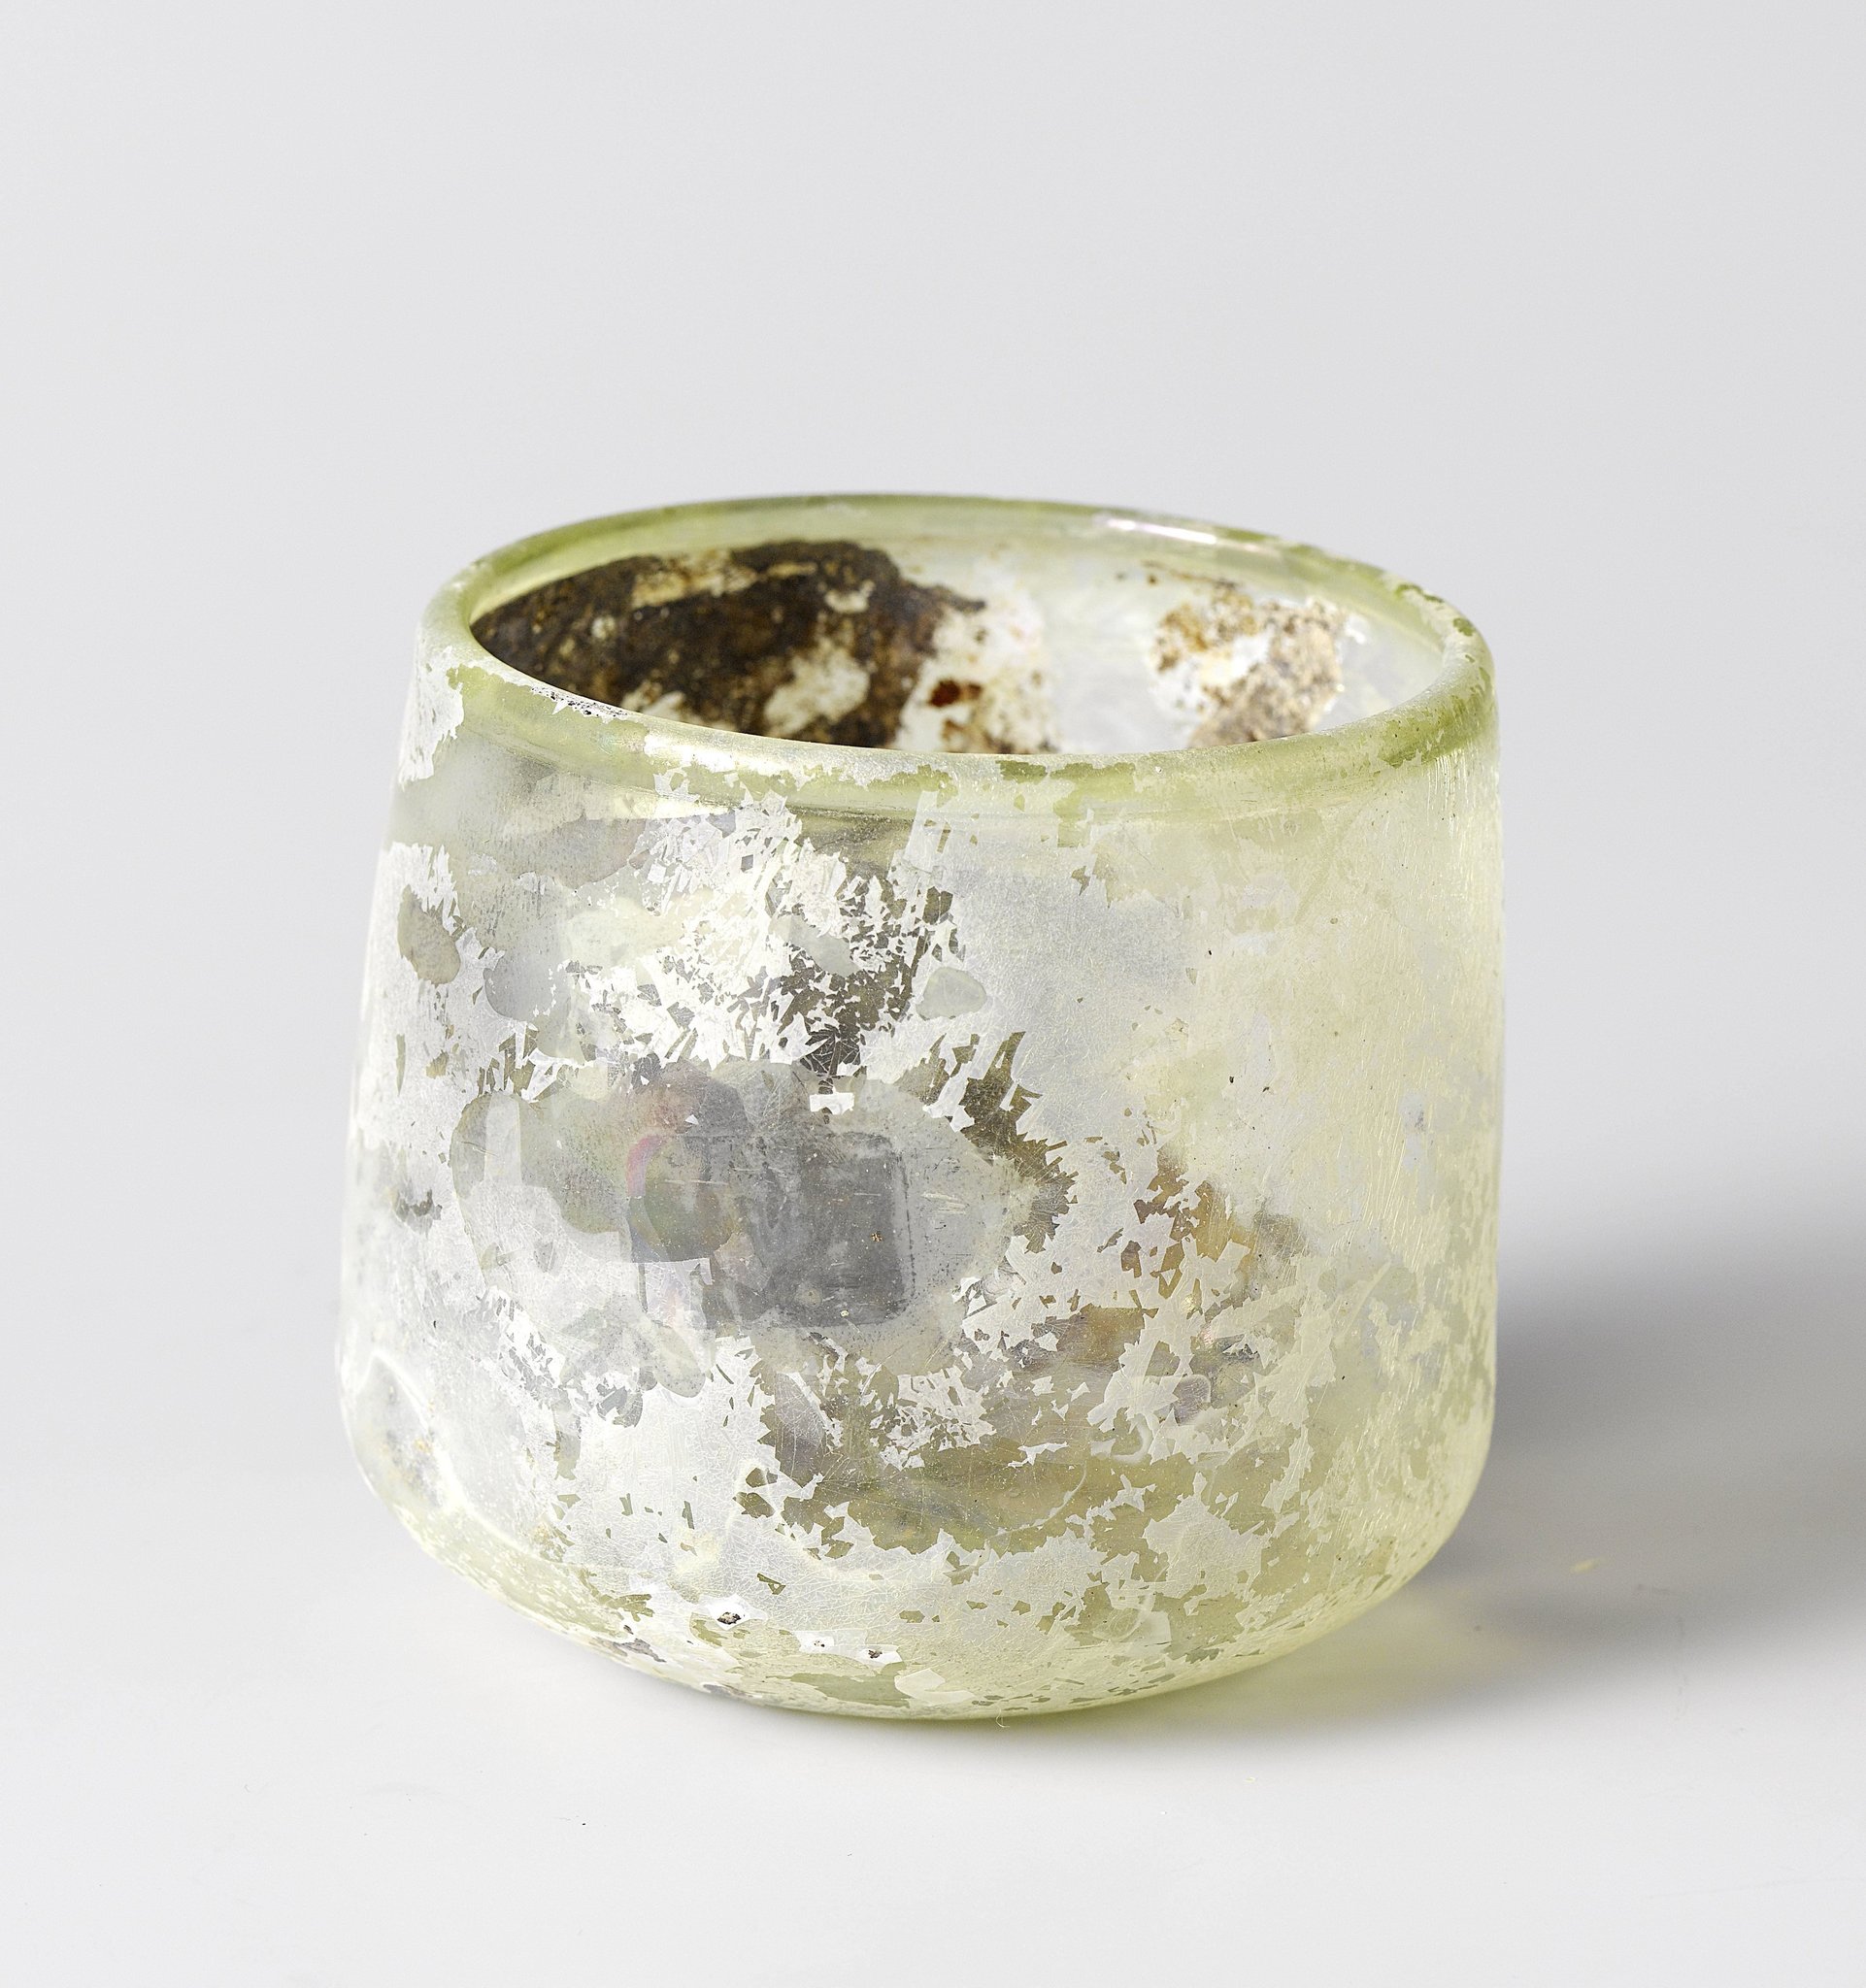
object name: drinking glass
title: Glas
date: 800-1399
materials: glass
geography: iran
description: Pot van kleurloos, licht geïriseerd glas met een holle bodem en een rechte, iets naar binnen staande wand. Naar binnen gekeerde lip.